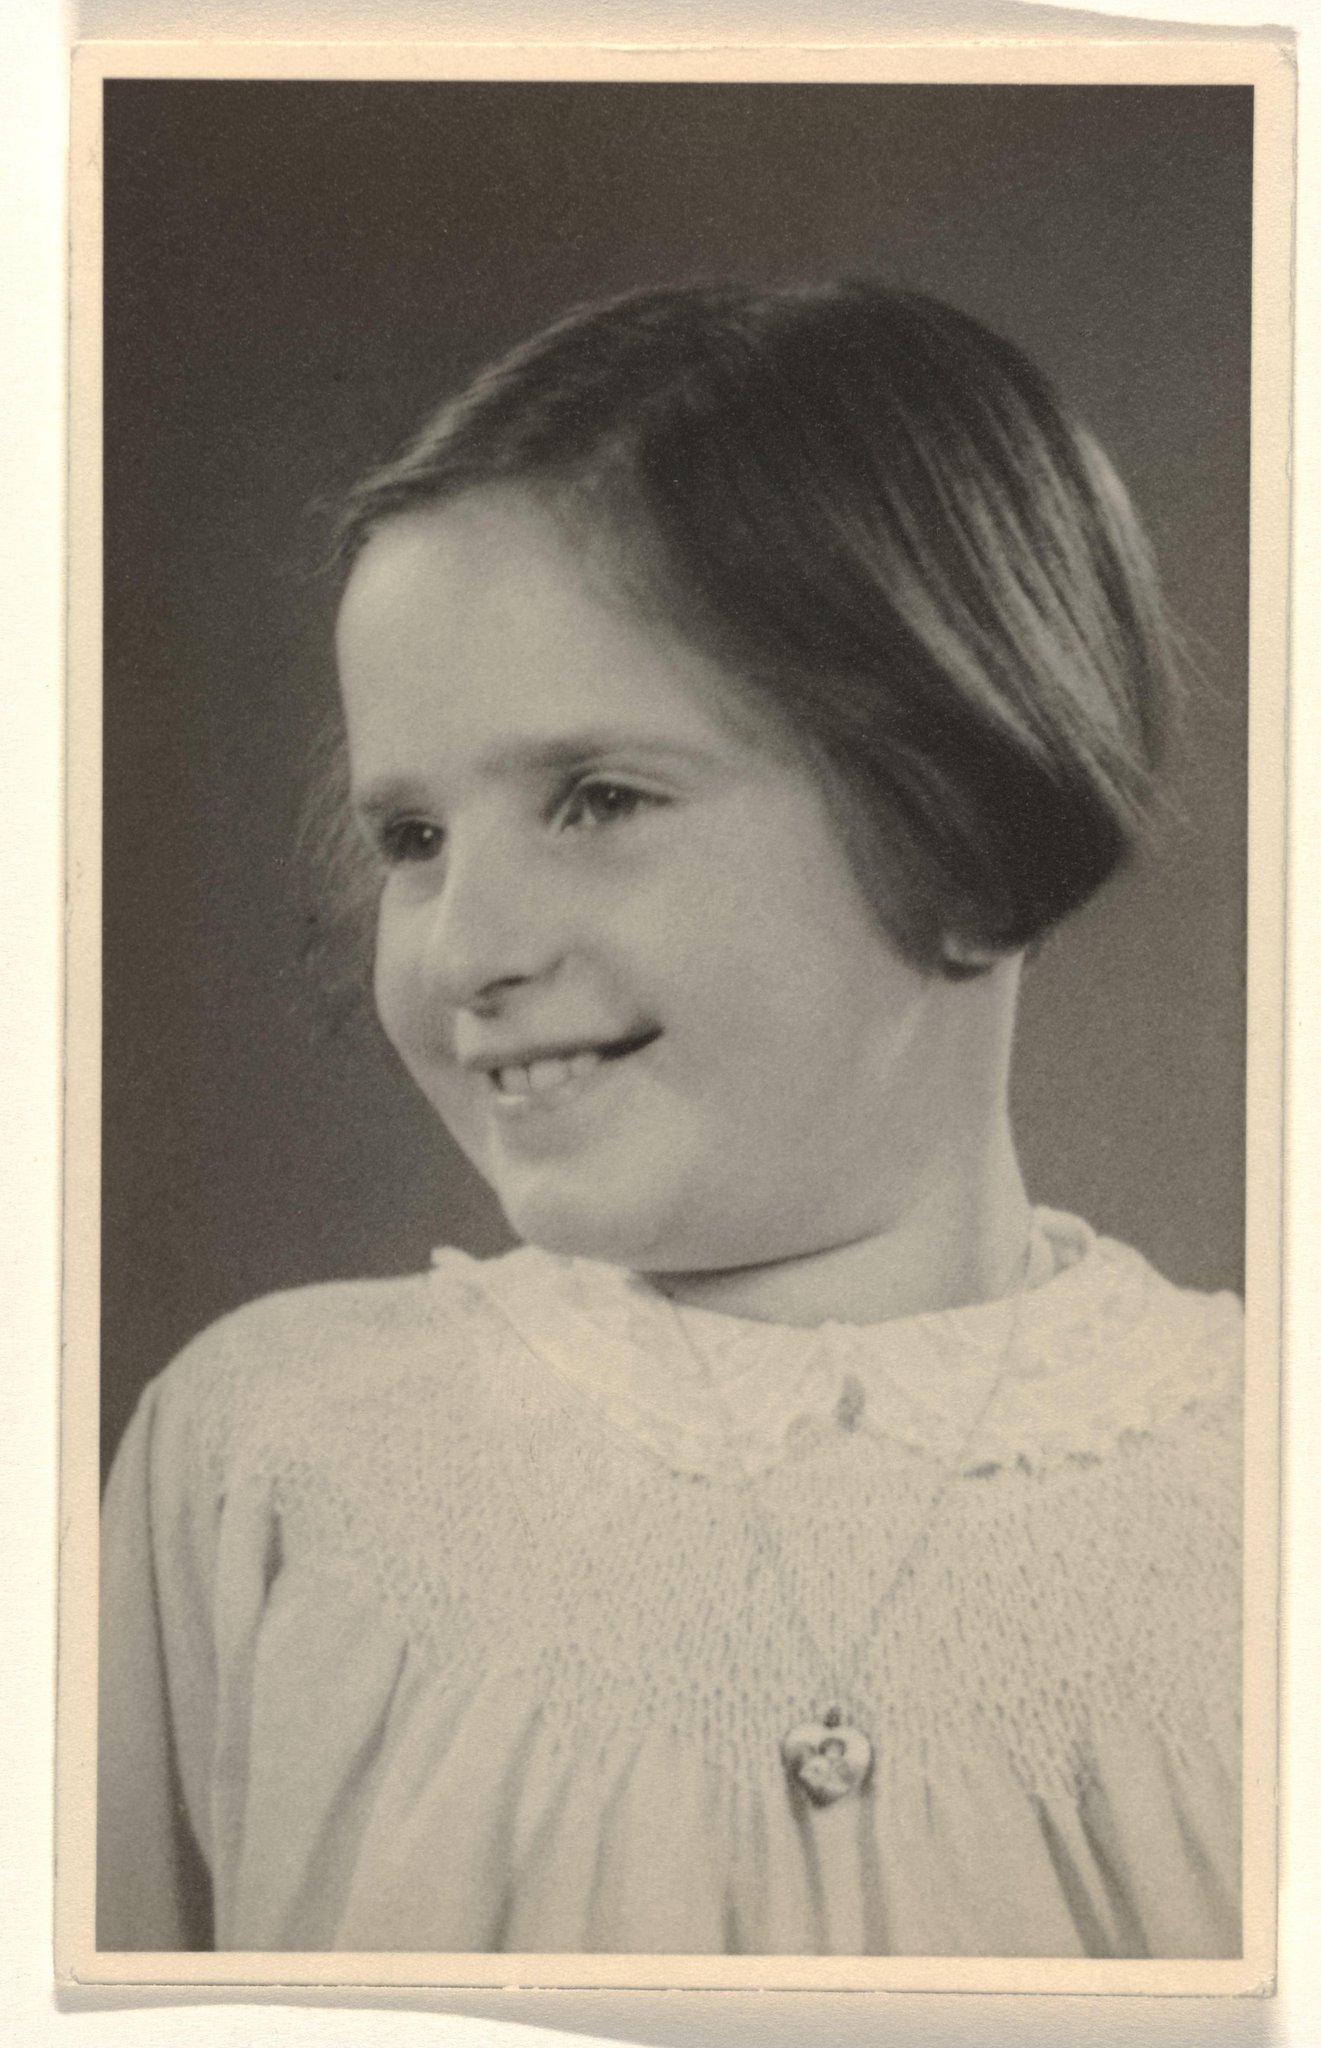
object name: photograph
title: Portret van Isabel Wachenheimer in Lysil, 1937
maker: Anonymous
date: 1937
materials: photographic support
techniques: gelatin silver print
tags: leiden, isabel wachenheimer-elon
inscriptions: inscription: ‘Isabel Maria Lysil 1937.’